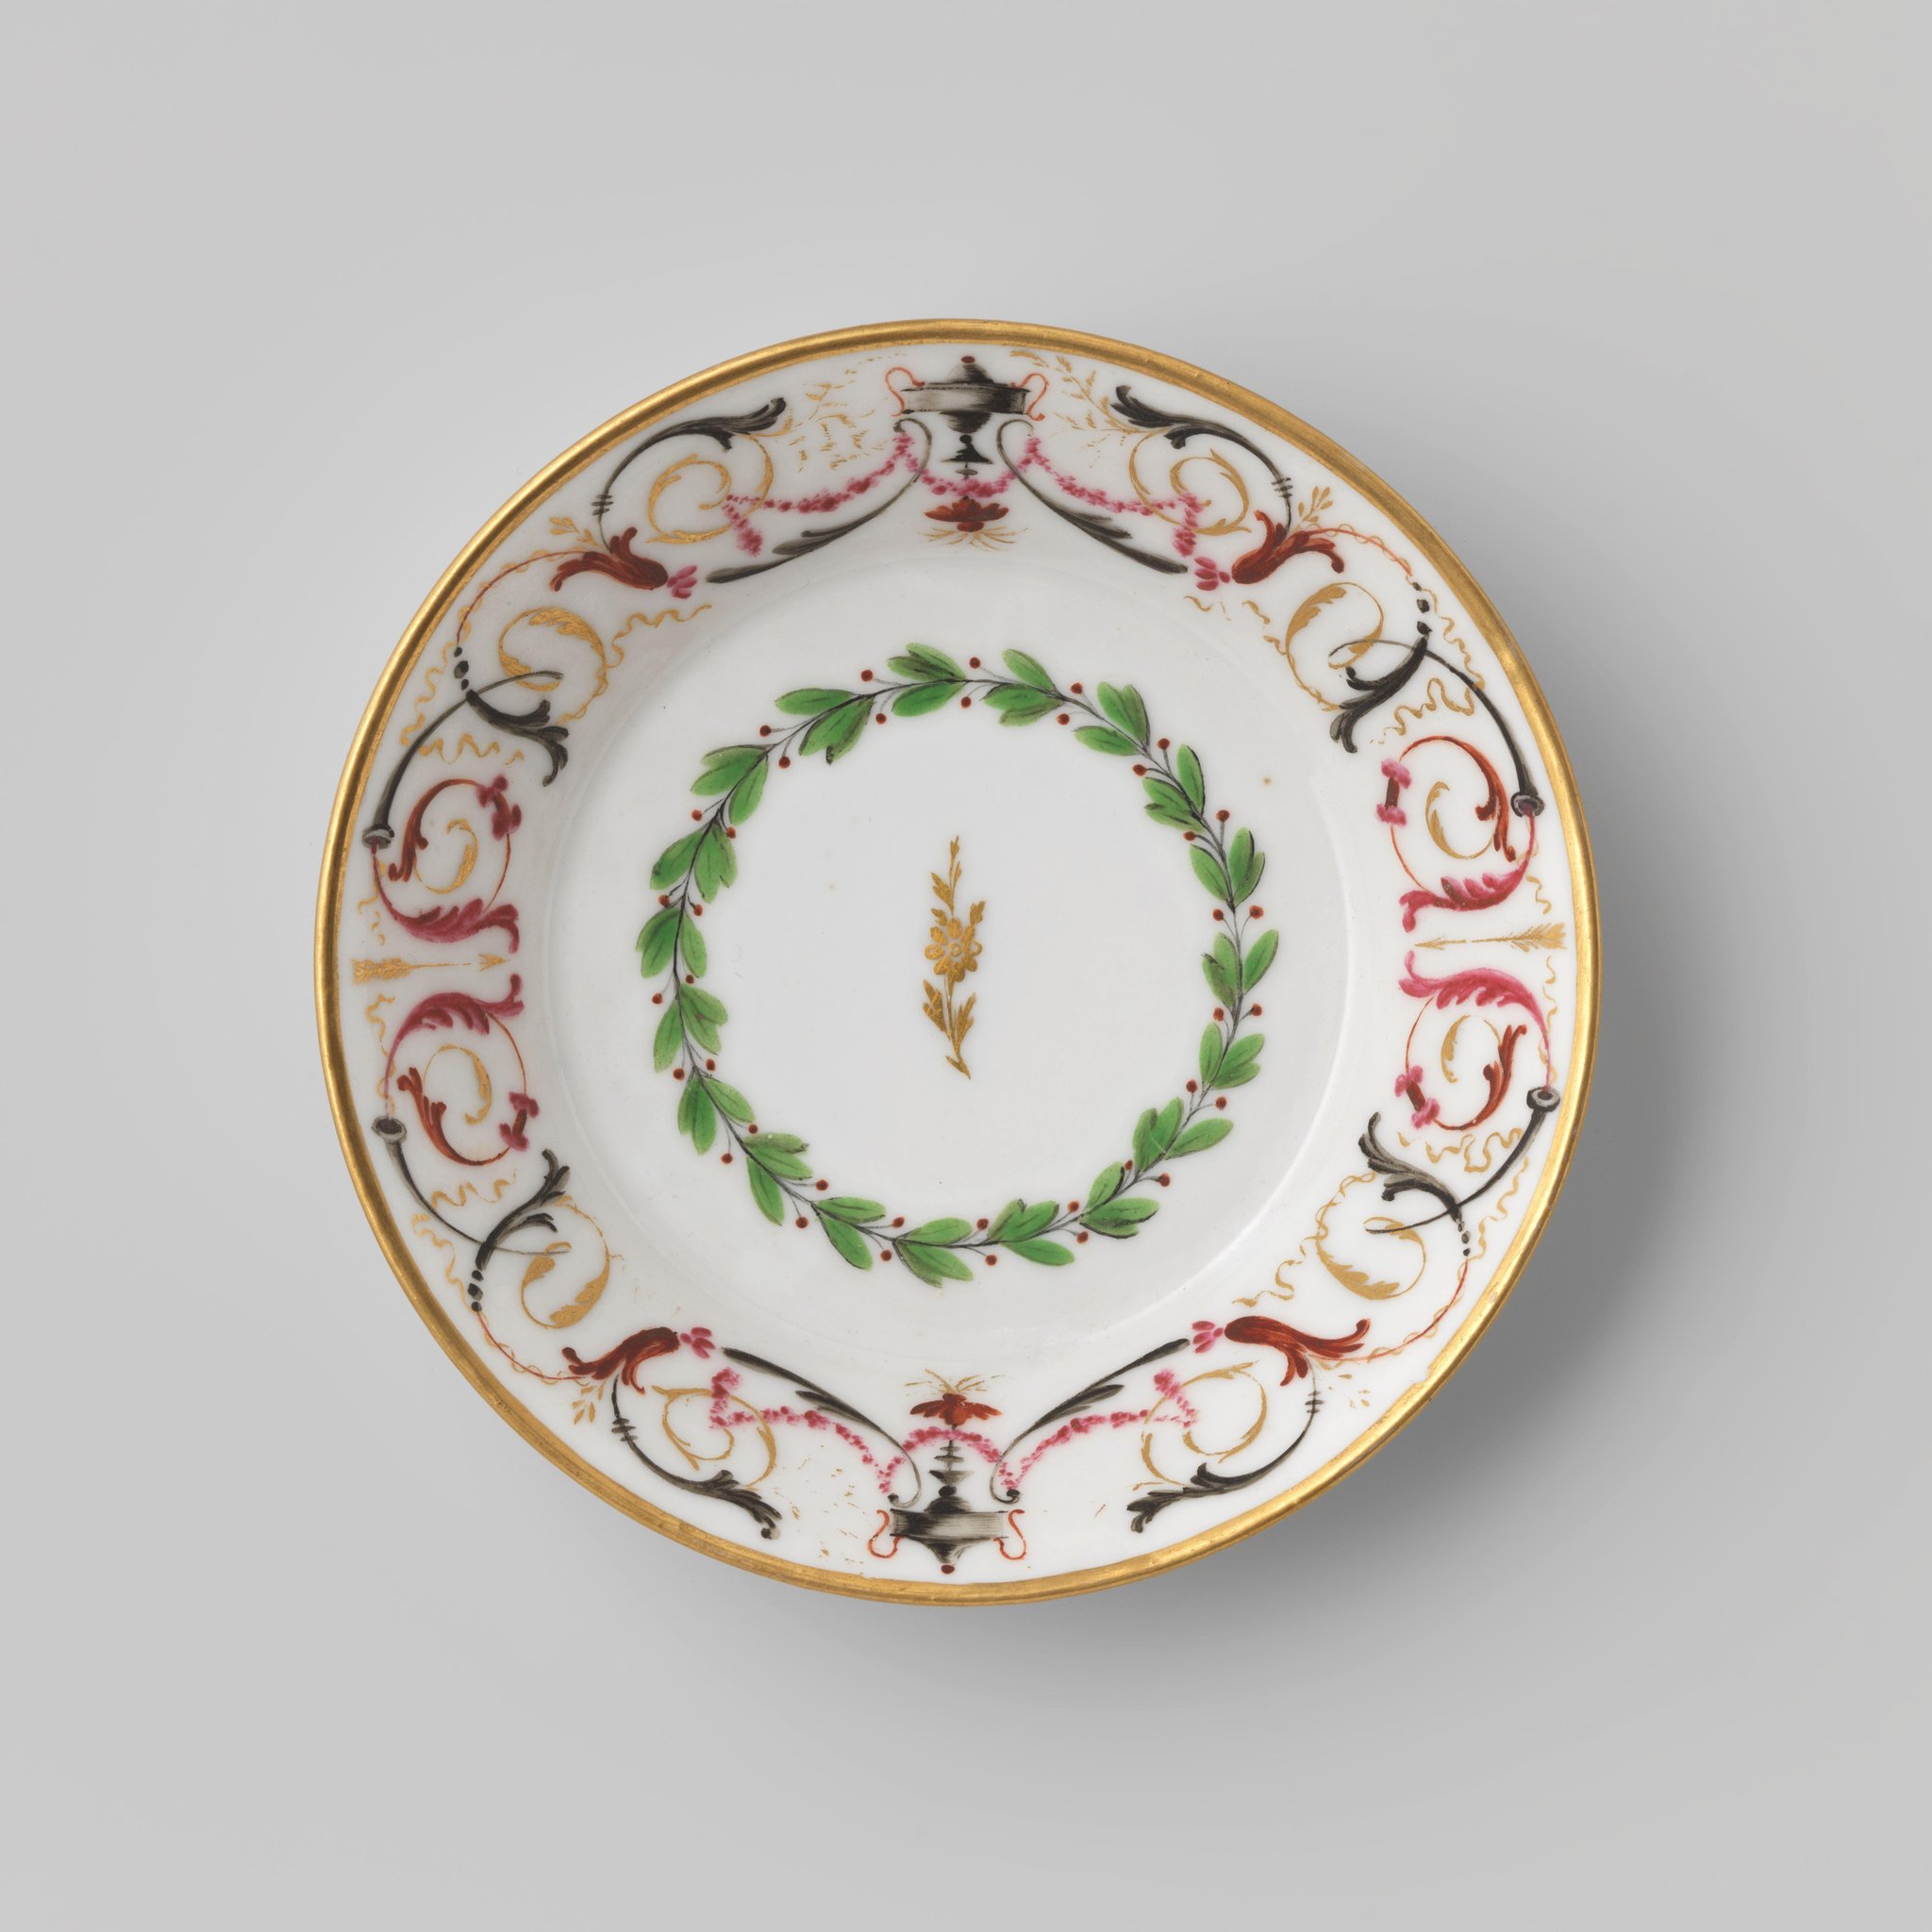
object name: platter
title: Saucer with foliate scrolls and a wreath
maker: Anonymous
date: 1790-1800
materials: glaze, gold, paint, porcelain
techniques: firing, forming, gilding, relief, turning, vitrification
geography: france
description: Schotel van porselein met een rechte wand, beschilderd op het glazuur in rood, roze, groen, zwart en goud. Op het plat een bloem in een bladerkrans. Op de wand een bladrank en een gouden band op de rand.